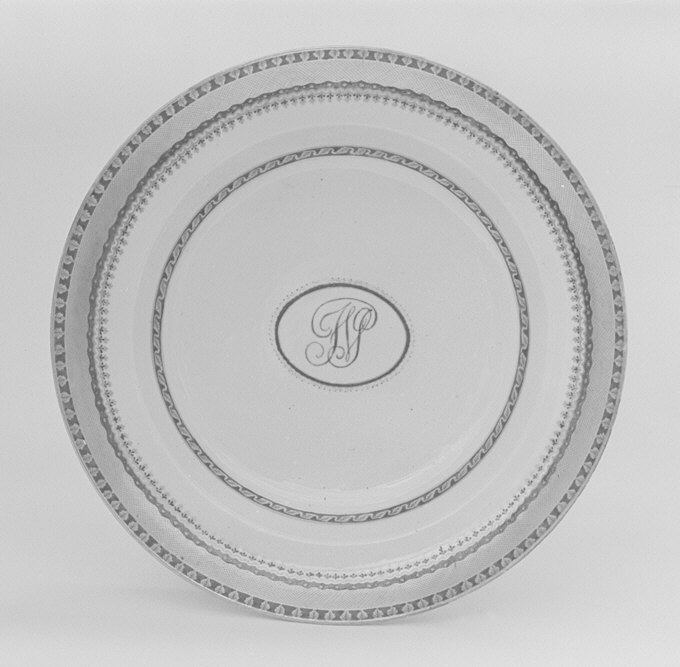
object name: soup plate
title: Soup plate (part of a service)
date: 1785-1800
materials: hard paste porcelain